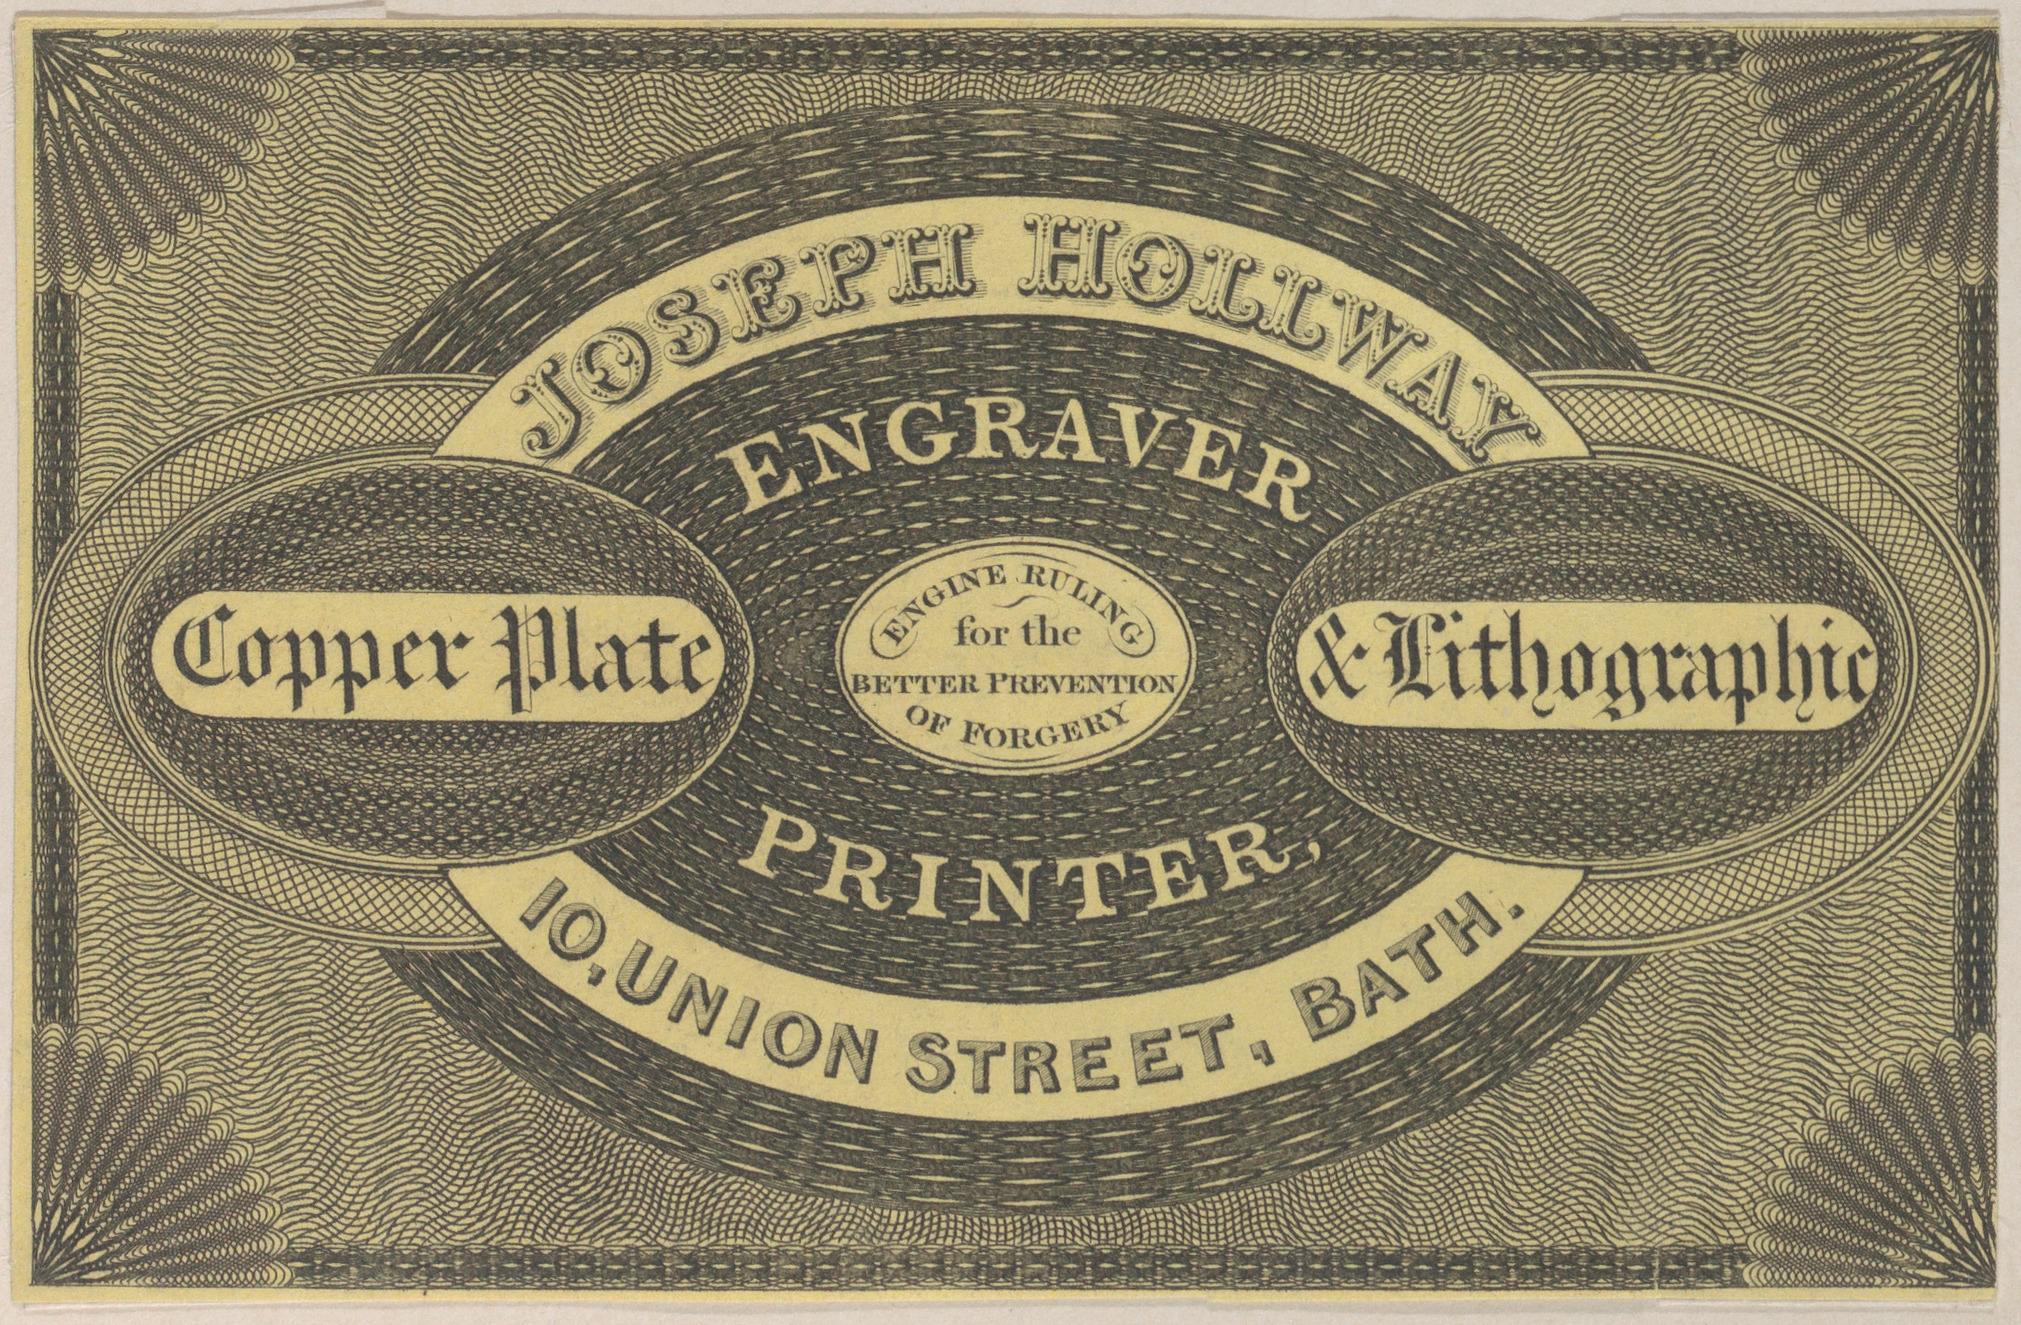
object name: print, trade card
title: Trade Card for Joseph Hollway, Engraver & Printer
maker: anonymous, british, 19th century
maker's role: artist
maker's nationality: british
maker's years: 1800-1900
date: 1801-1900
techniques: engraving